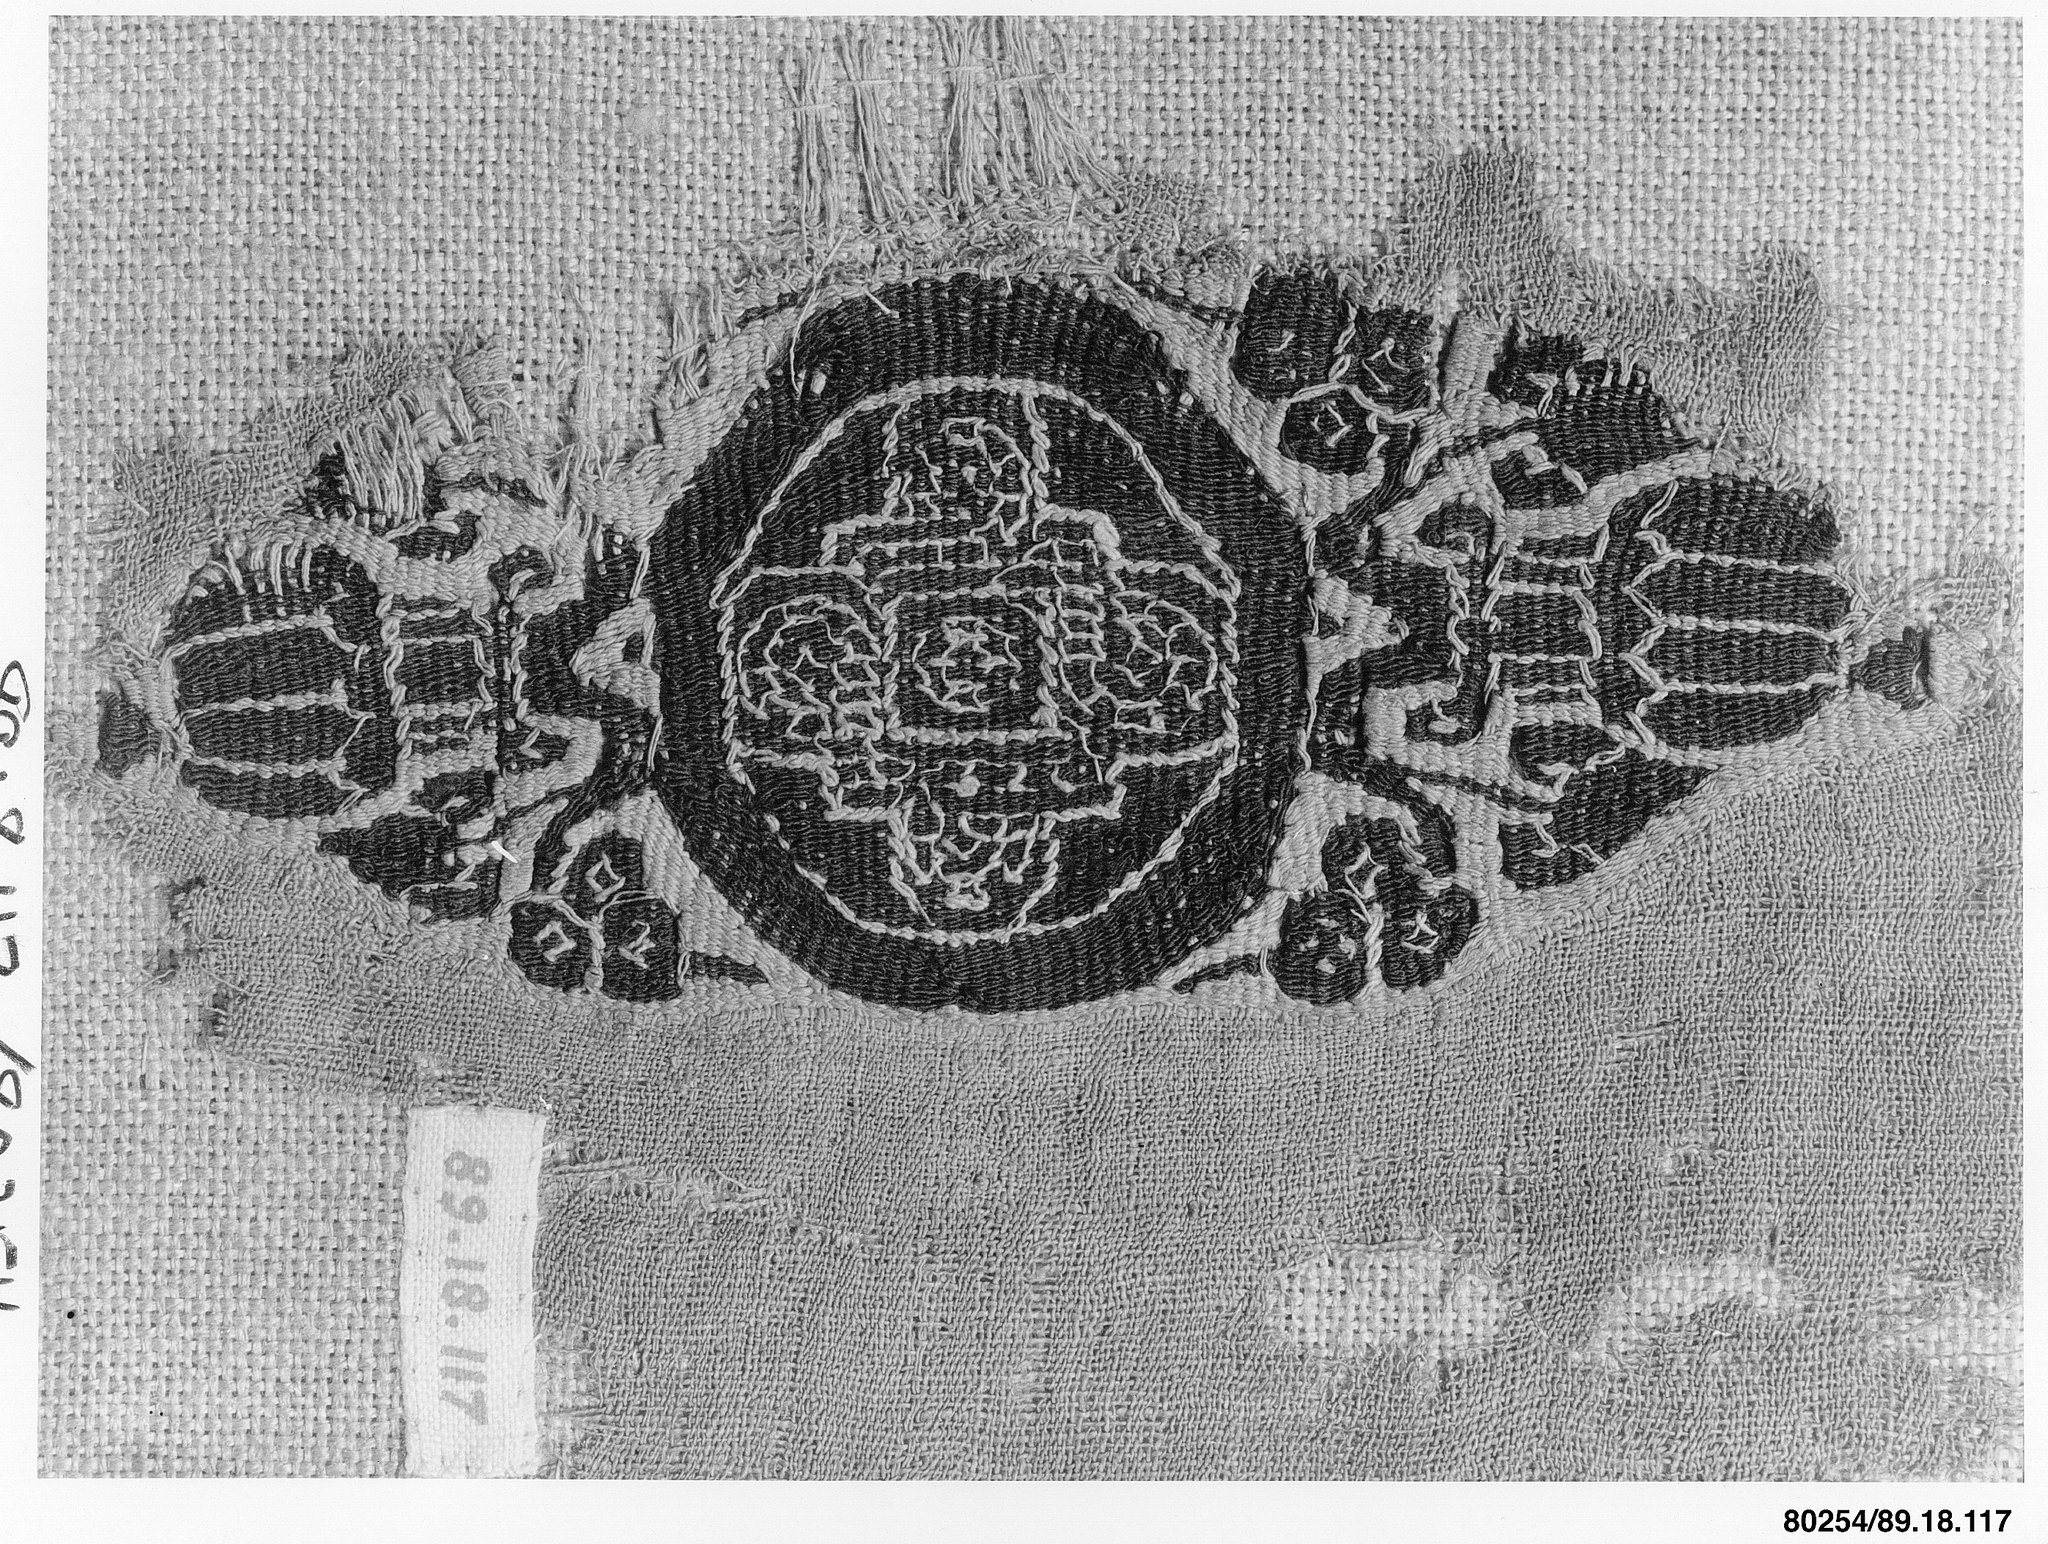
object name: textile fragment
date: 301-400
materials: linen, wool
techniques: weave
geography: egypt